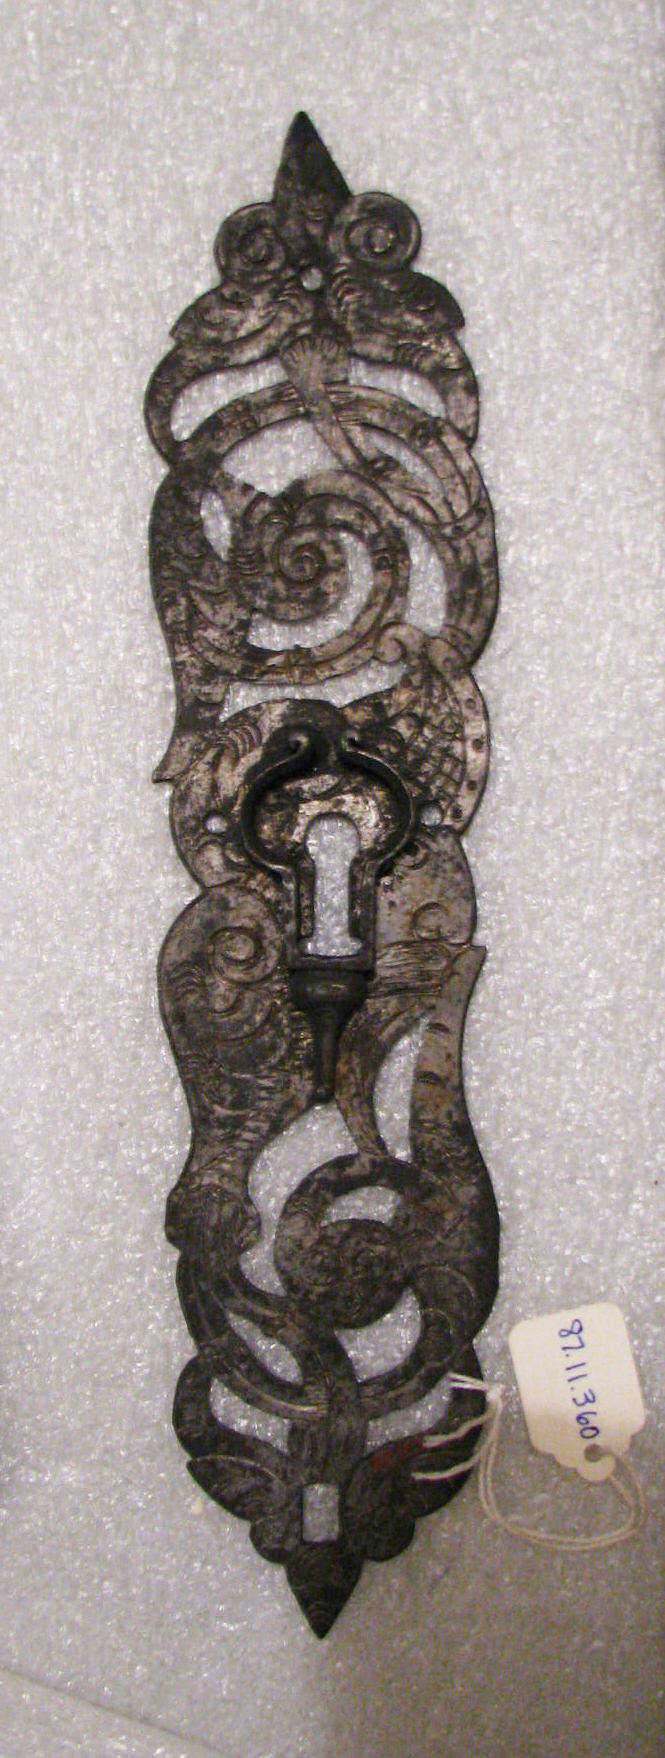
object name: escutcheon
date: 1560-1620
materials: iron